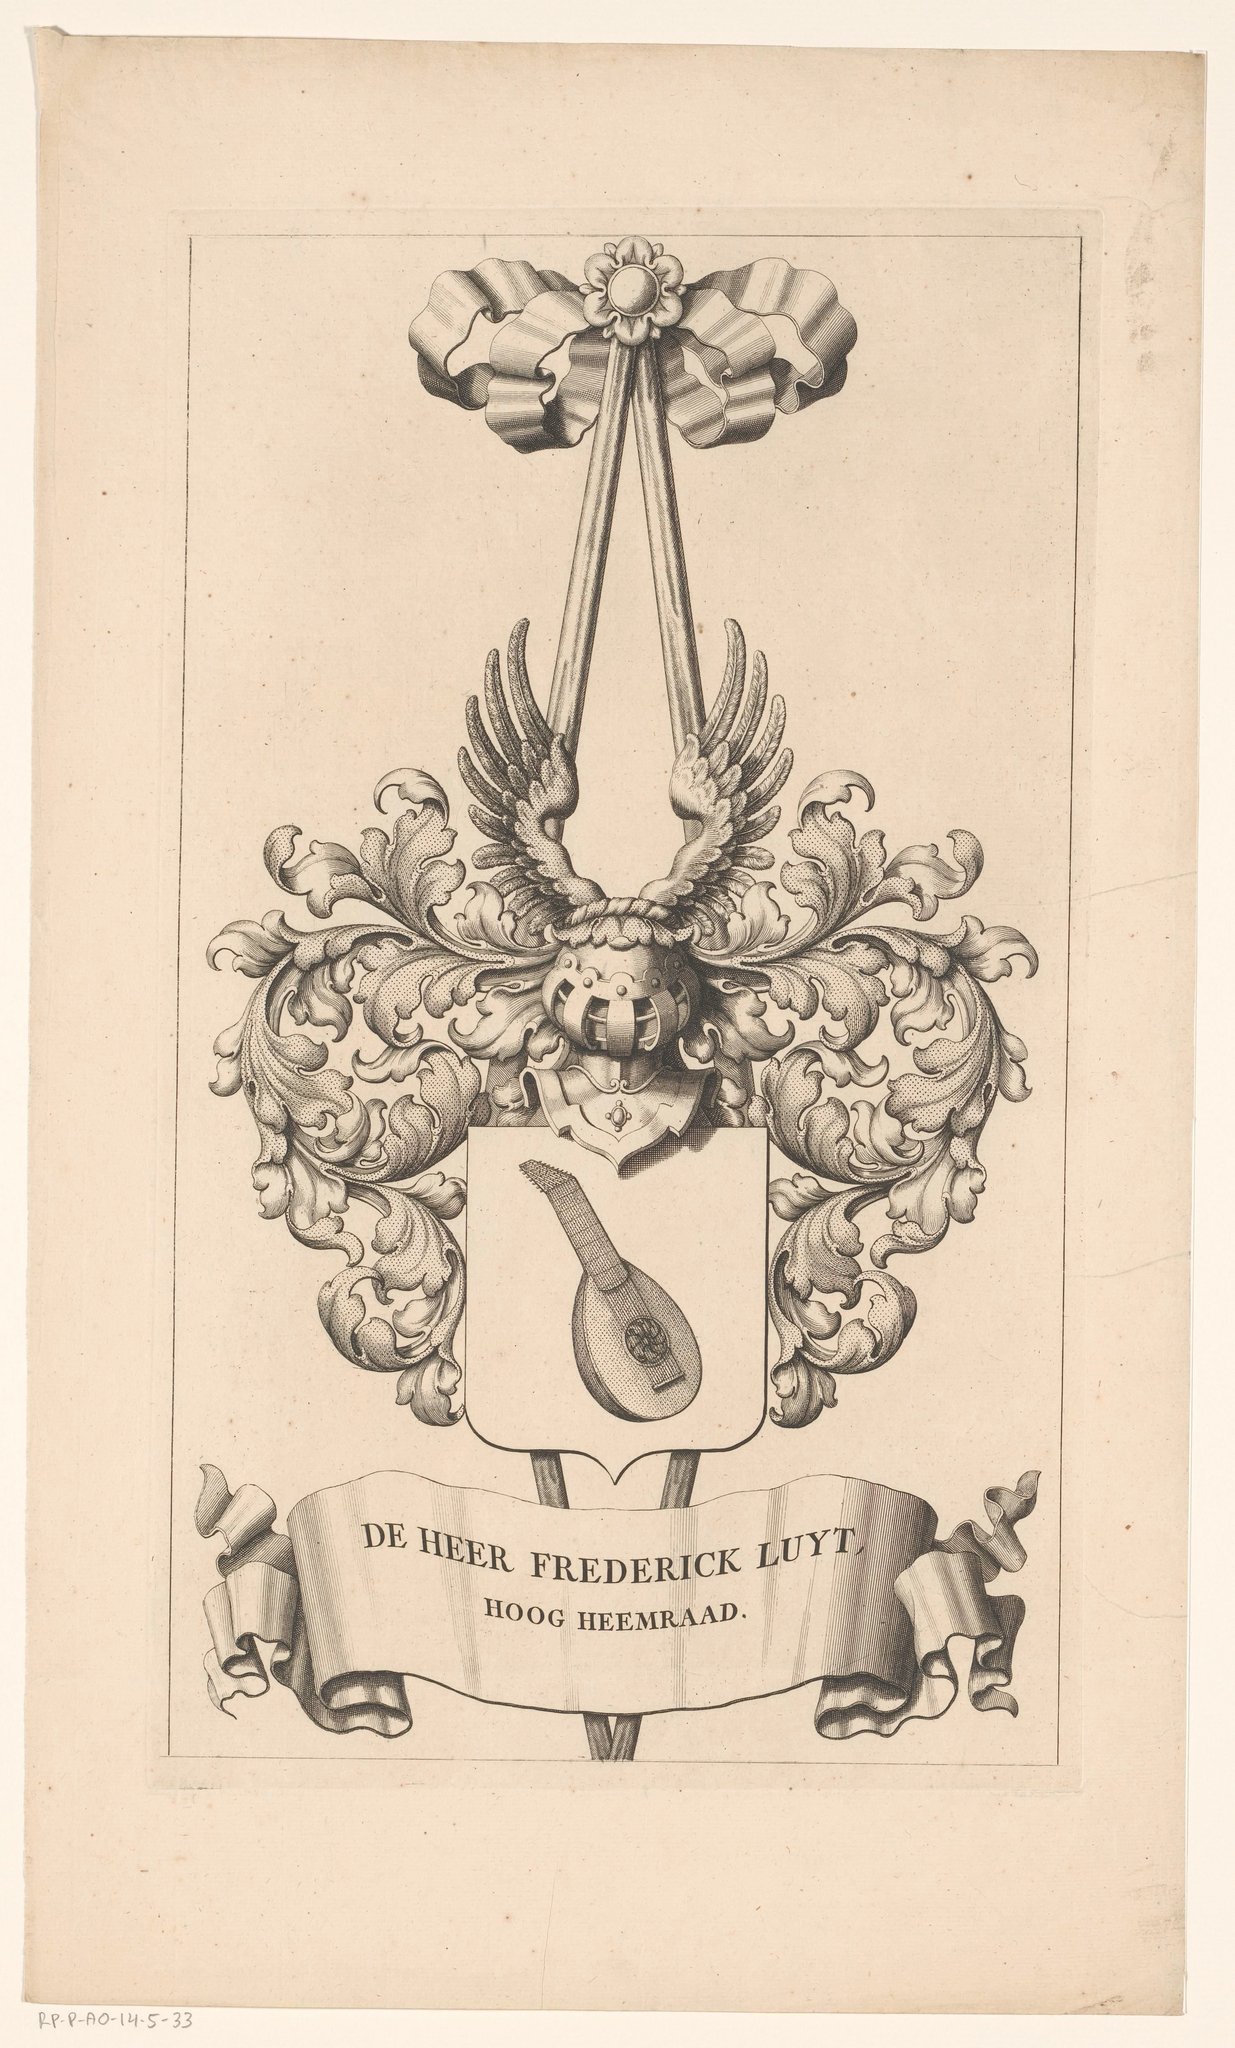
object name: print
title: Het Hooge Heemraadschap van de Crimpenre Waard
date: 1683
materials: paper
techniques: engraving, etching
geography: amsterdam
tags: armorial bearing, heraldry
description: Deel van de wapenrand van de vijfde druk van 'Het Hooge Heemraadschap van de Crimpenre Waard', een wandkaart (bestaande uit een kaart en een wapenrand) van het Hoogheemraadschap van de Krimpenerwaard.